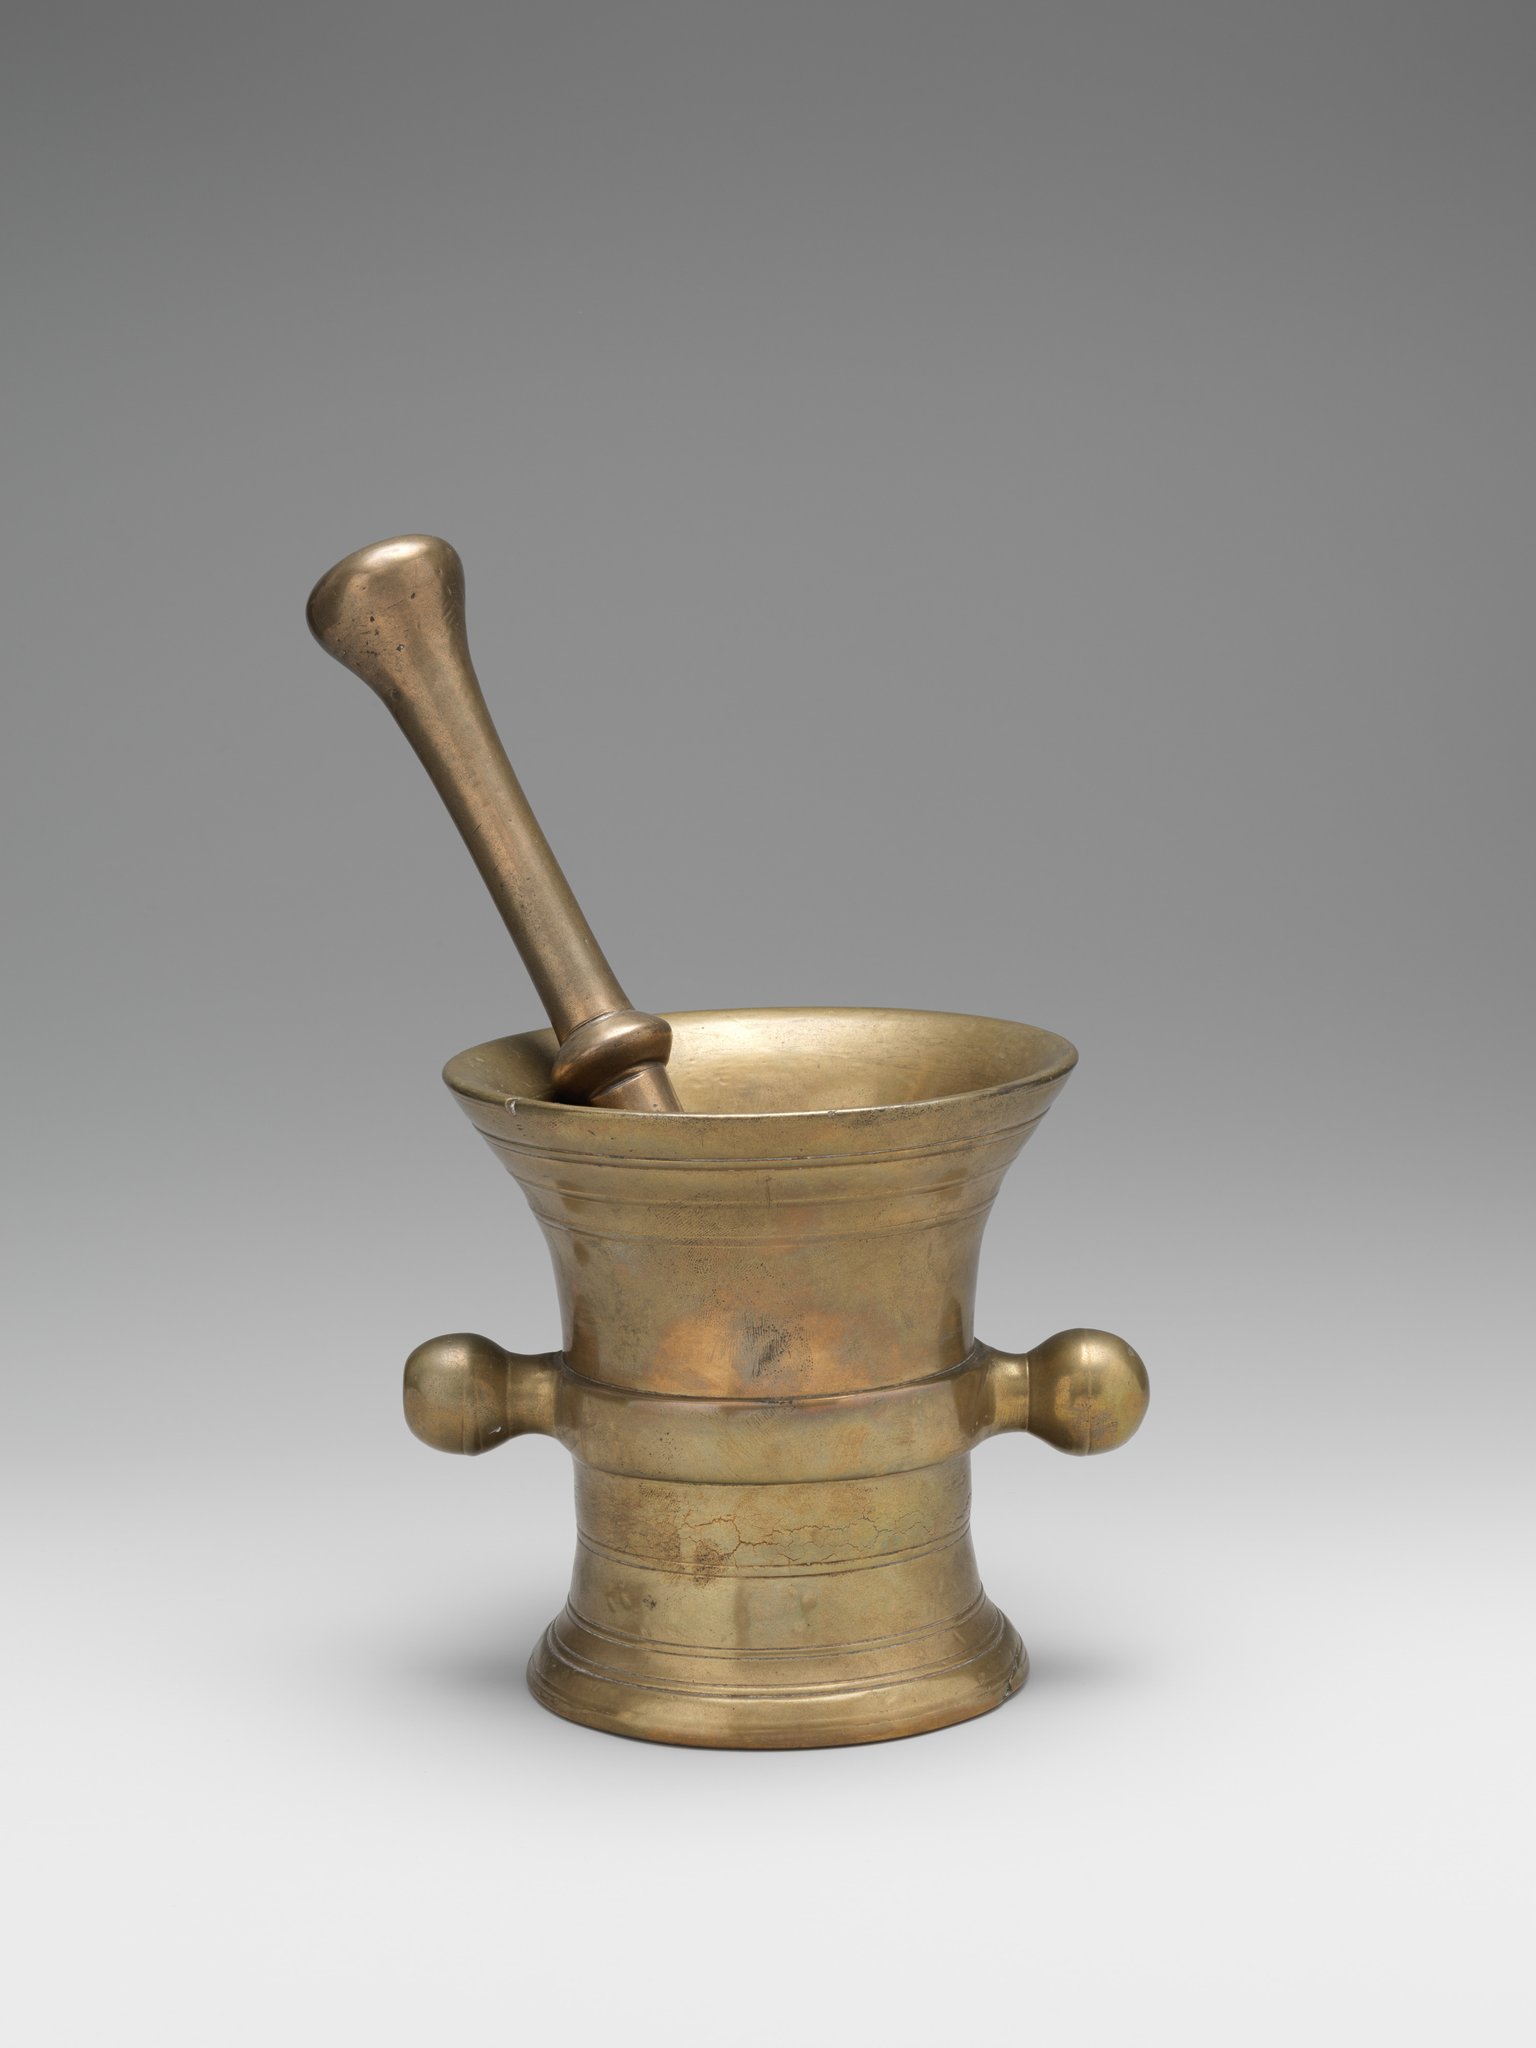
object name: mortar and pestle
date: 1751-1800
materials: brass